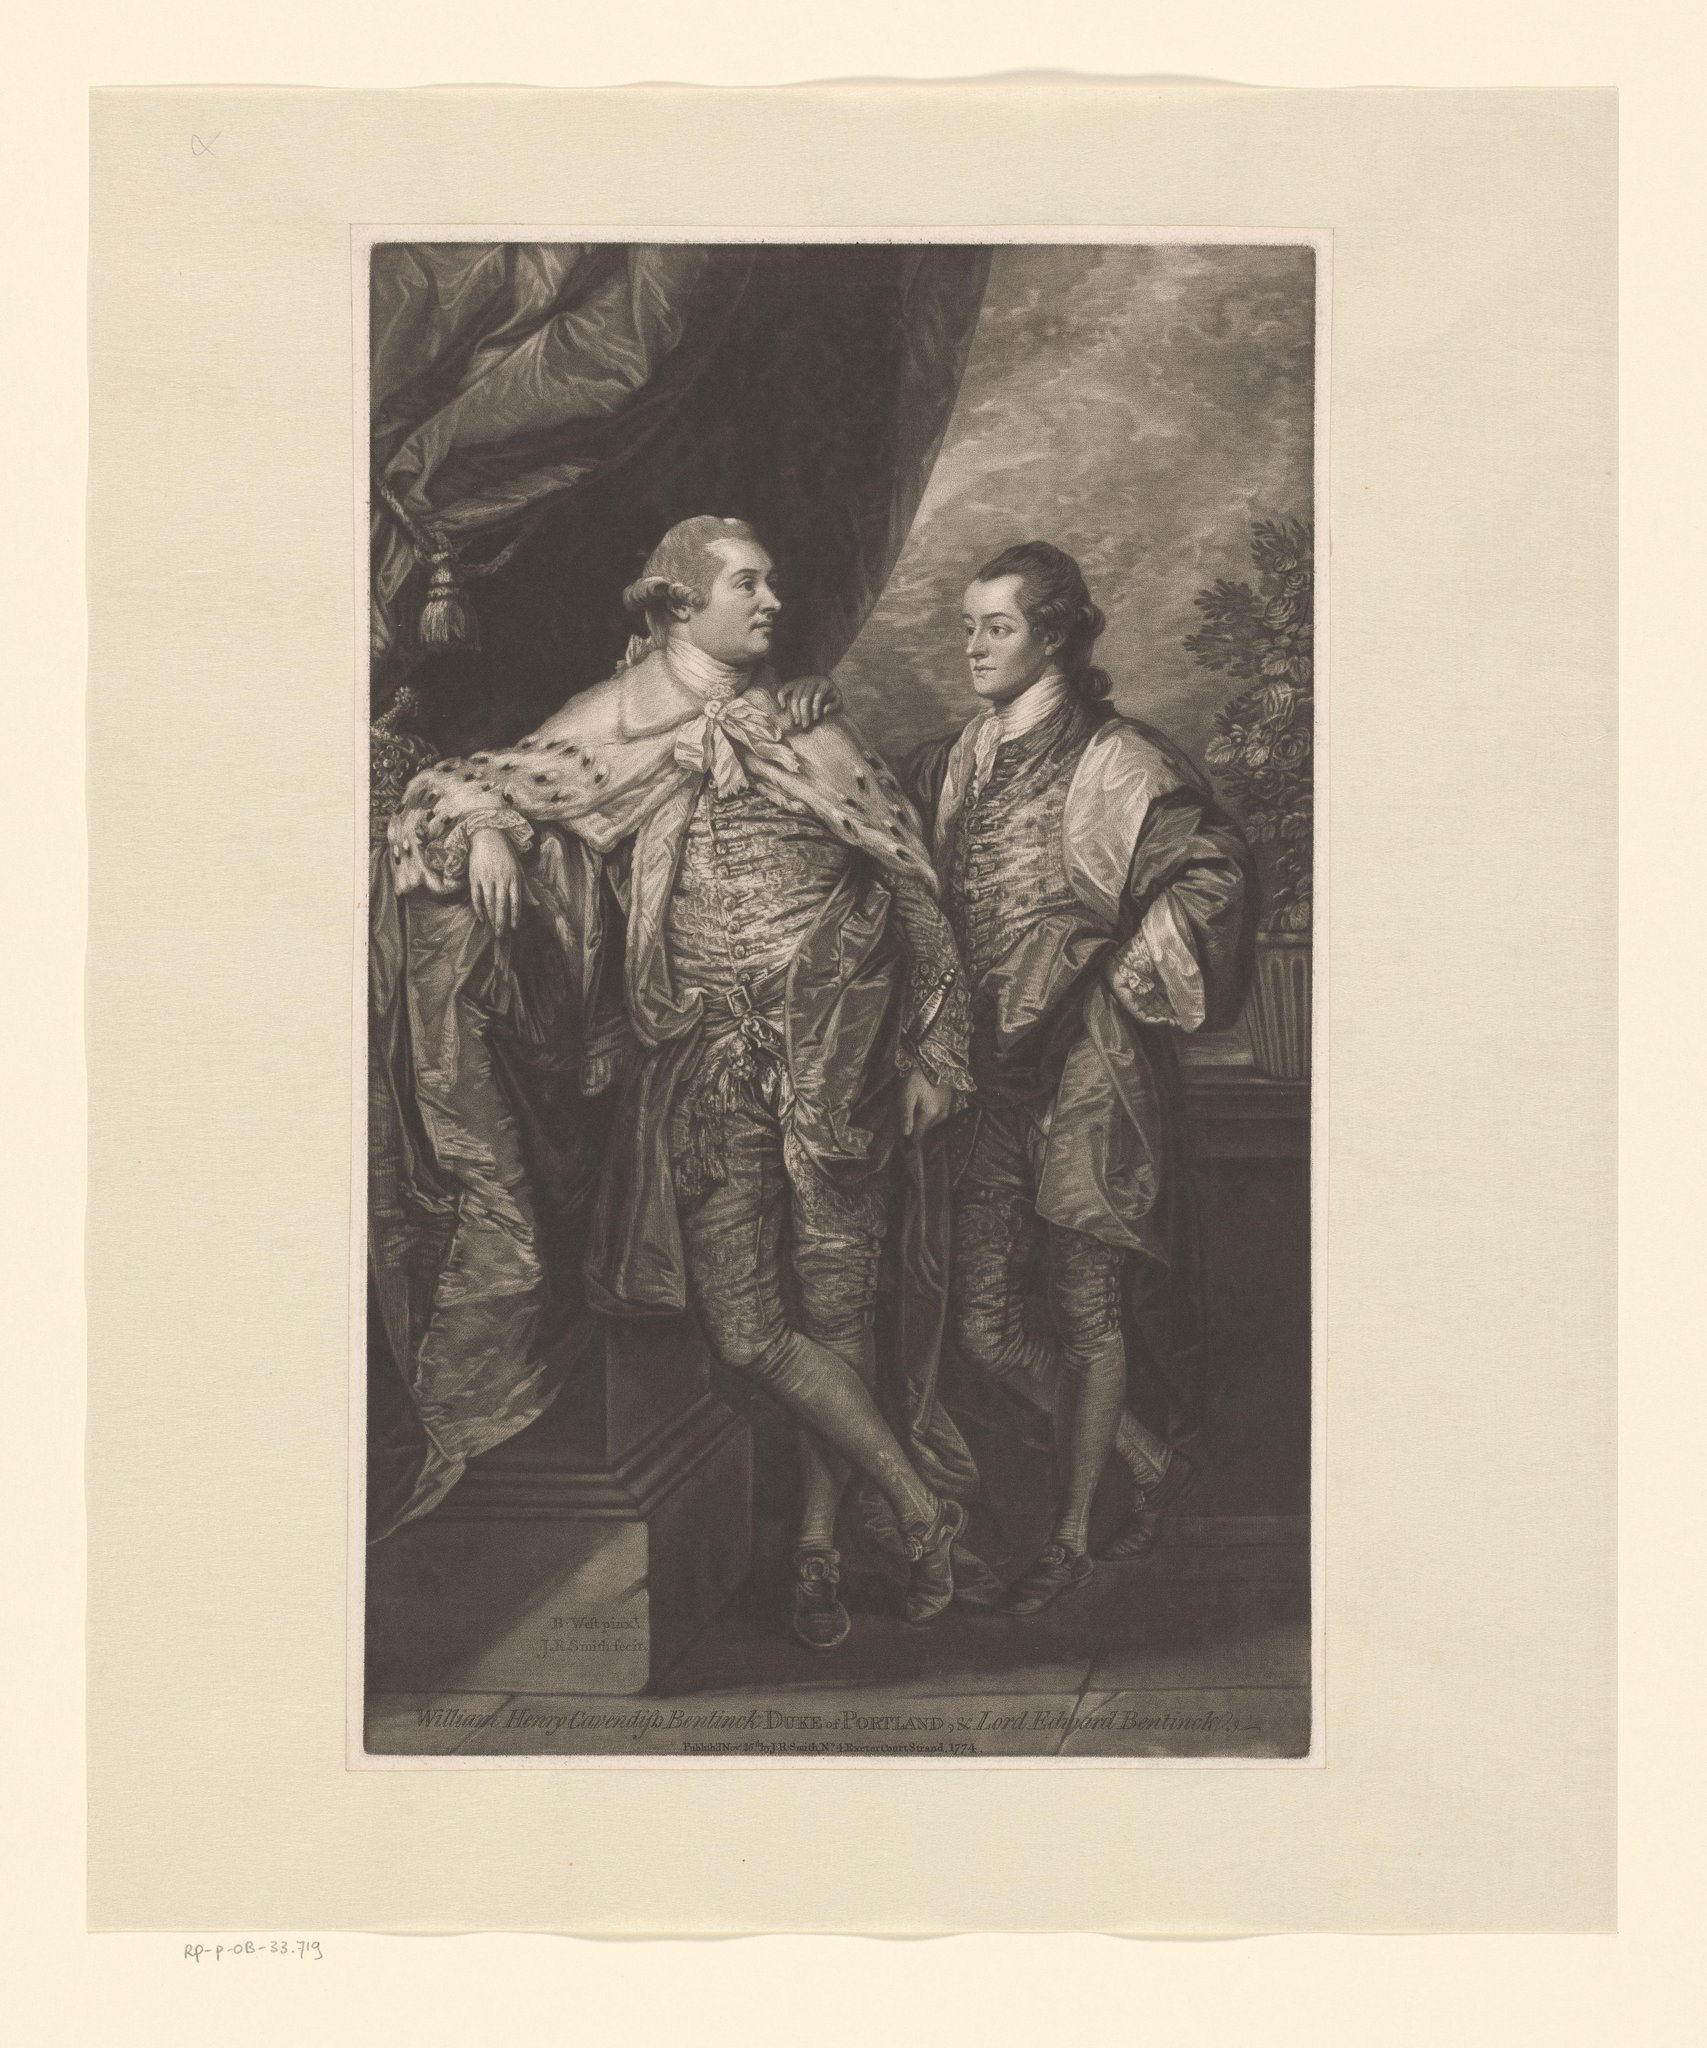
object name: print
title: Portret van William Henry Cavendish-Bentinck en Edward Bentinck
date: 1711-1774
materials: paper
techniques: mezzotint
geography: london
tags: historical person in a double portrait, politician, e.g. party leader, brothers (second degree family relationships)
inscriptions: collector's mark: Lugt 240